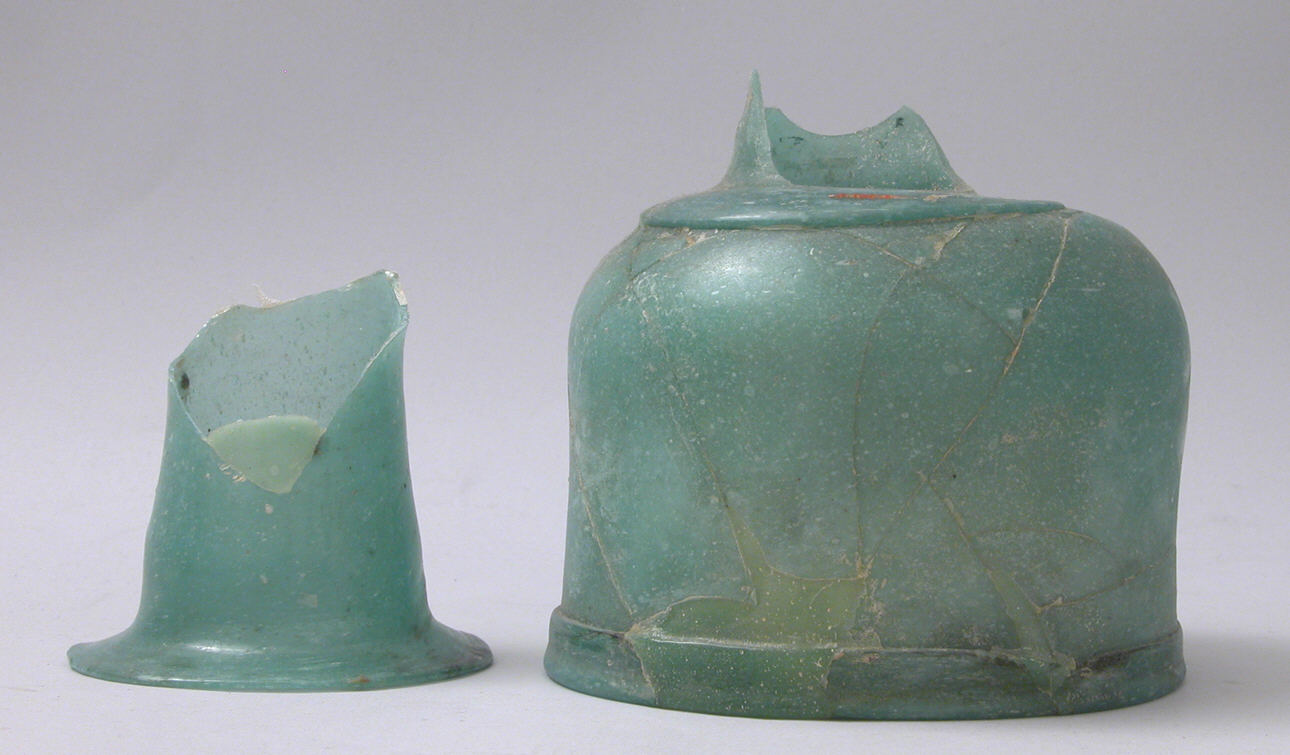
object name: chalice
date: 201-1200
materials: glass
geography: egypt